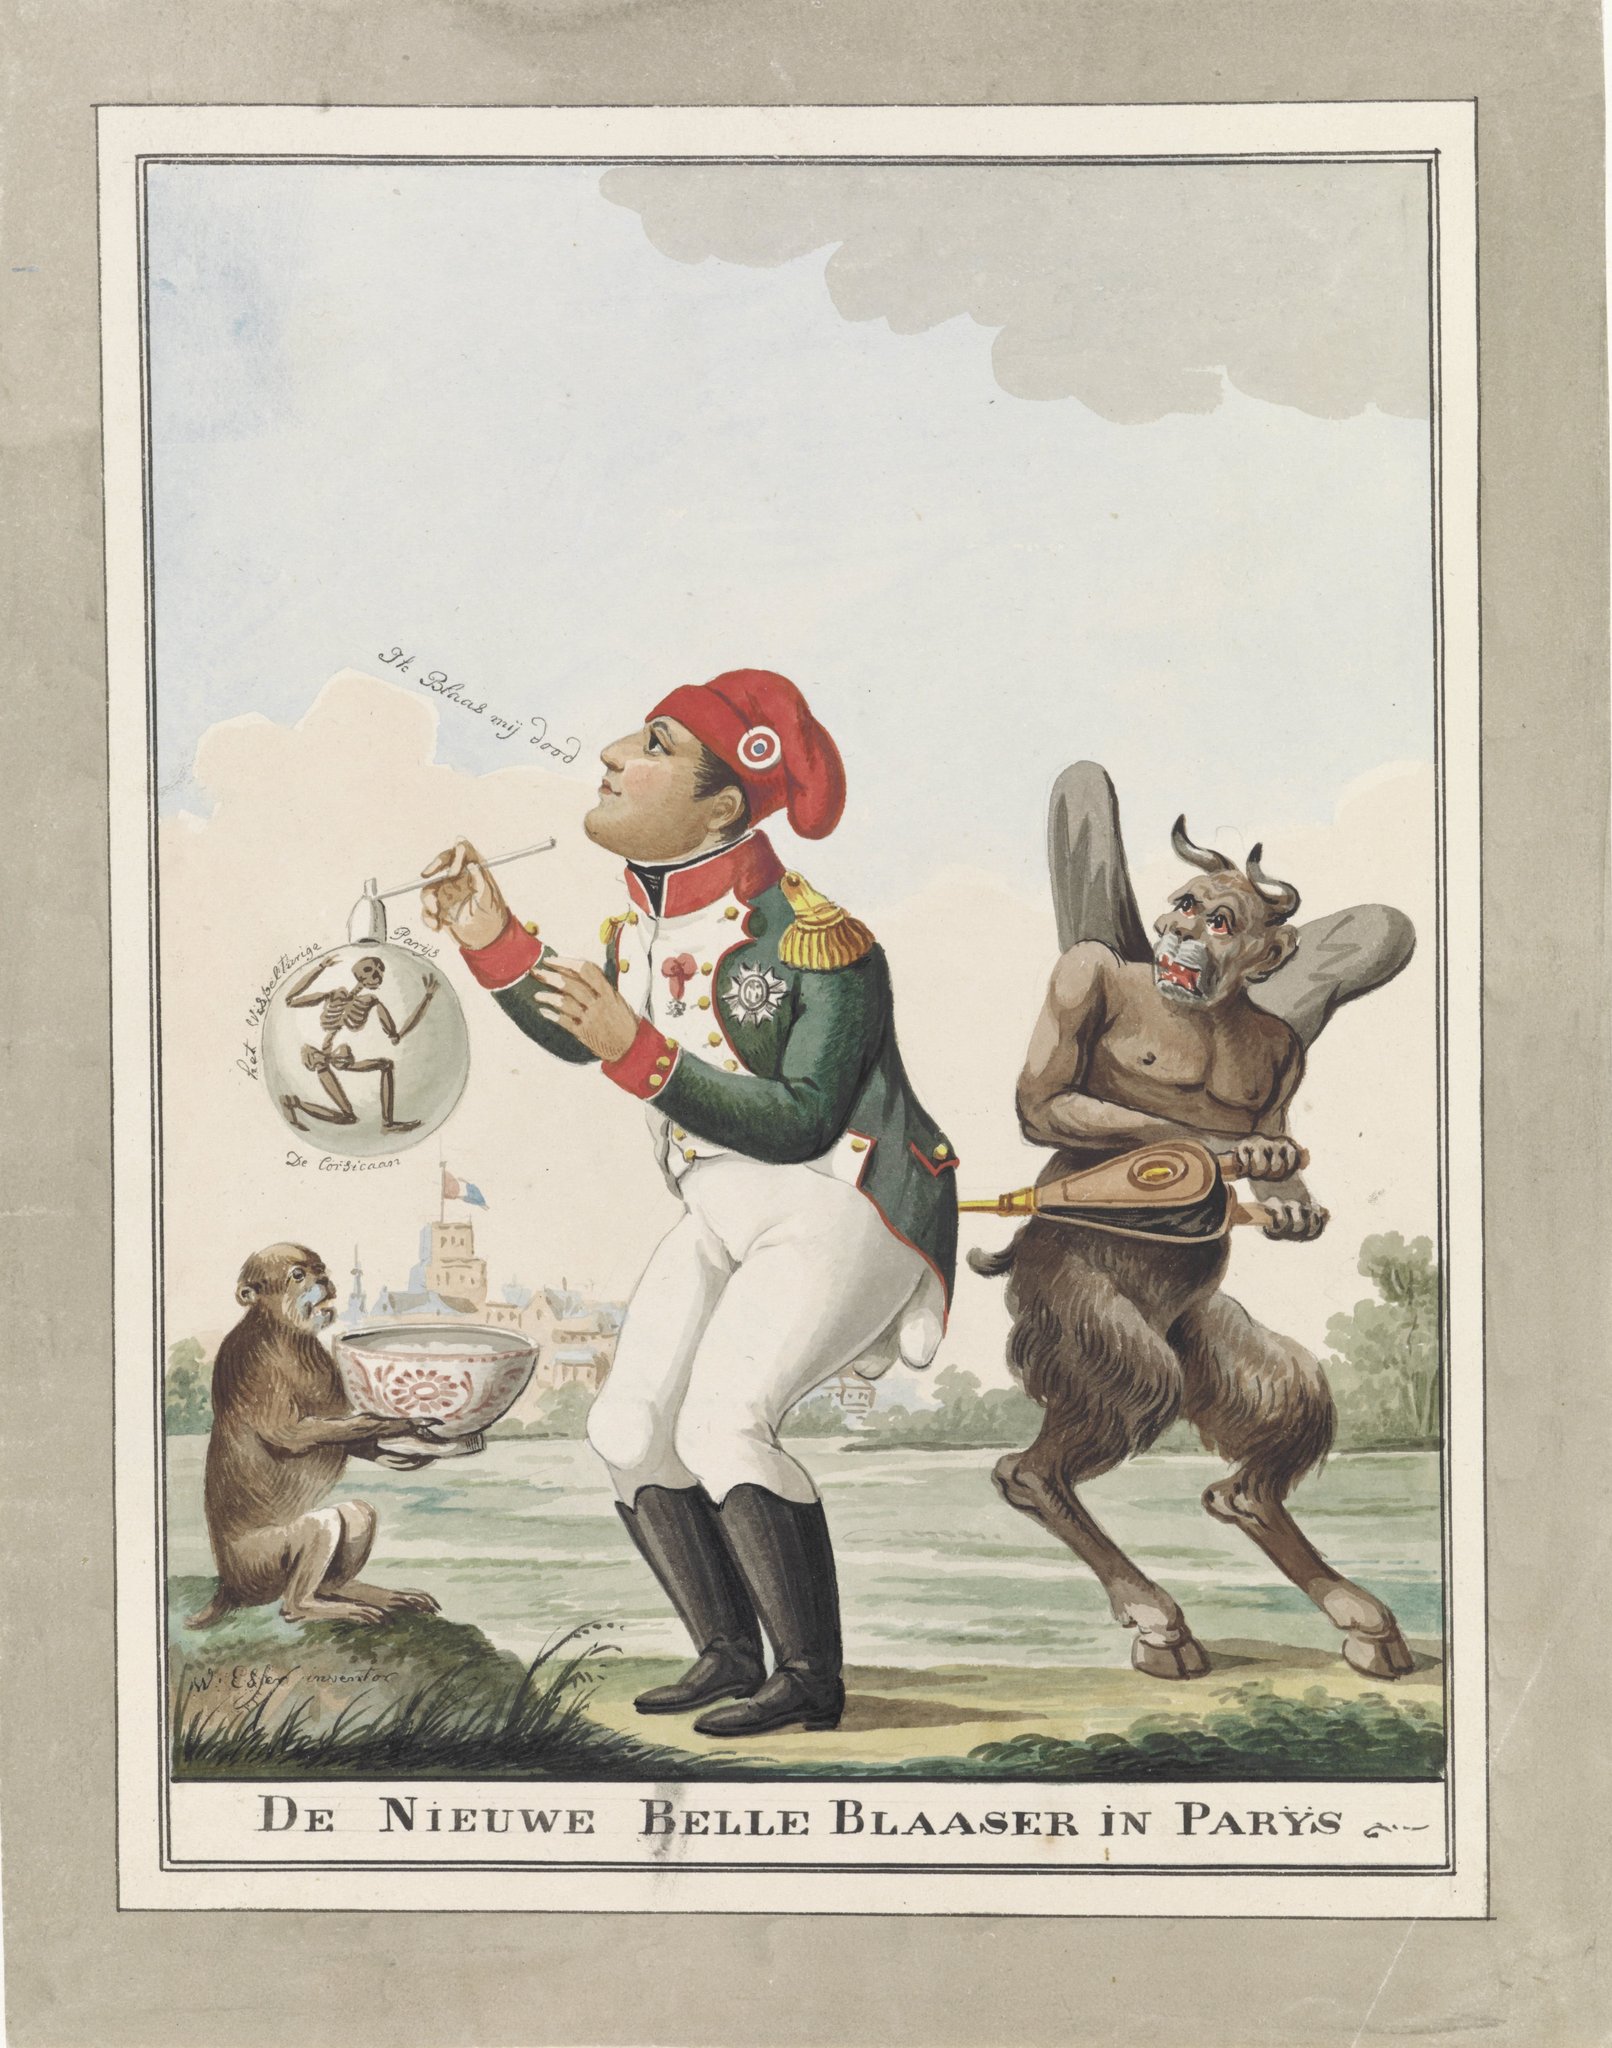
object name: cartoon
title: Napoleon als bellenblazer, 1815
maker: wijnand esser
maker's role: draughtsman, print maker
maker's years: 1779-1860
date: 1815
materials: paper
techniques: brush, pen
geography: netherlands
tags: napoleon i (emperor of the french), (children or putti) blowing bubbles, 'homo bulla' ~ scene symbolizing 'vanitas', paris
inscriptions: collector's mark: Lugt 2228, inscription: ‘Bij W: Esser kunstkooper Inventoor van Caricature Teege Napoleon. inde Spuijstraat Letter S No 31 te Saage’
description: Spotprent op Napoleons vruchteloze pogingen om, na zijn verlies bij Waterloo op 18 juni 1815, bij terugkeer in Parijs de stad voor zich te winnen. Napoleon met Jacobijnenmuts op, een zeepbel blazend waarbinnen de dood als een skelet. Rechts blaast de duivel hem in met een blaasbalg, links een aap die het zeepsop voorhoudt.